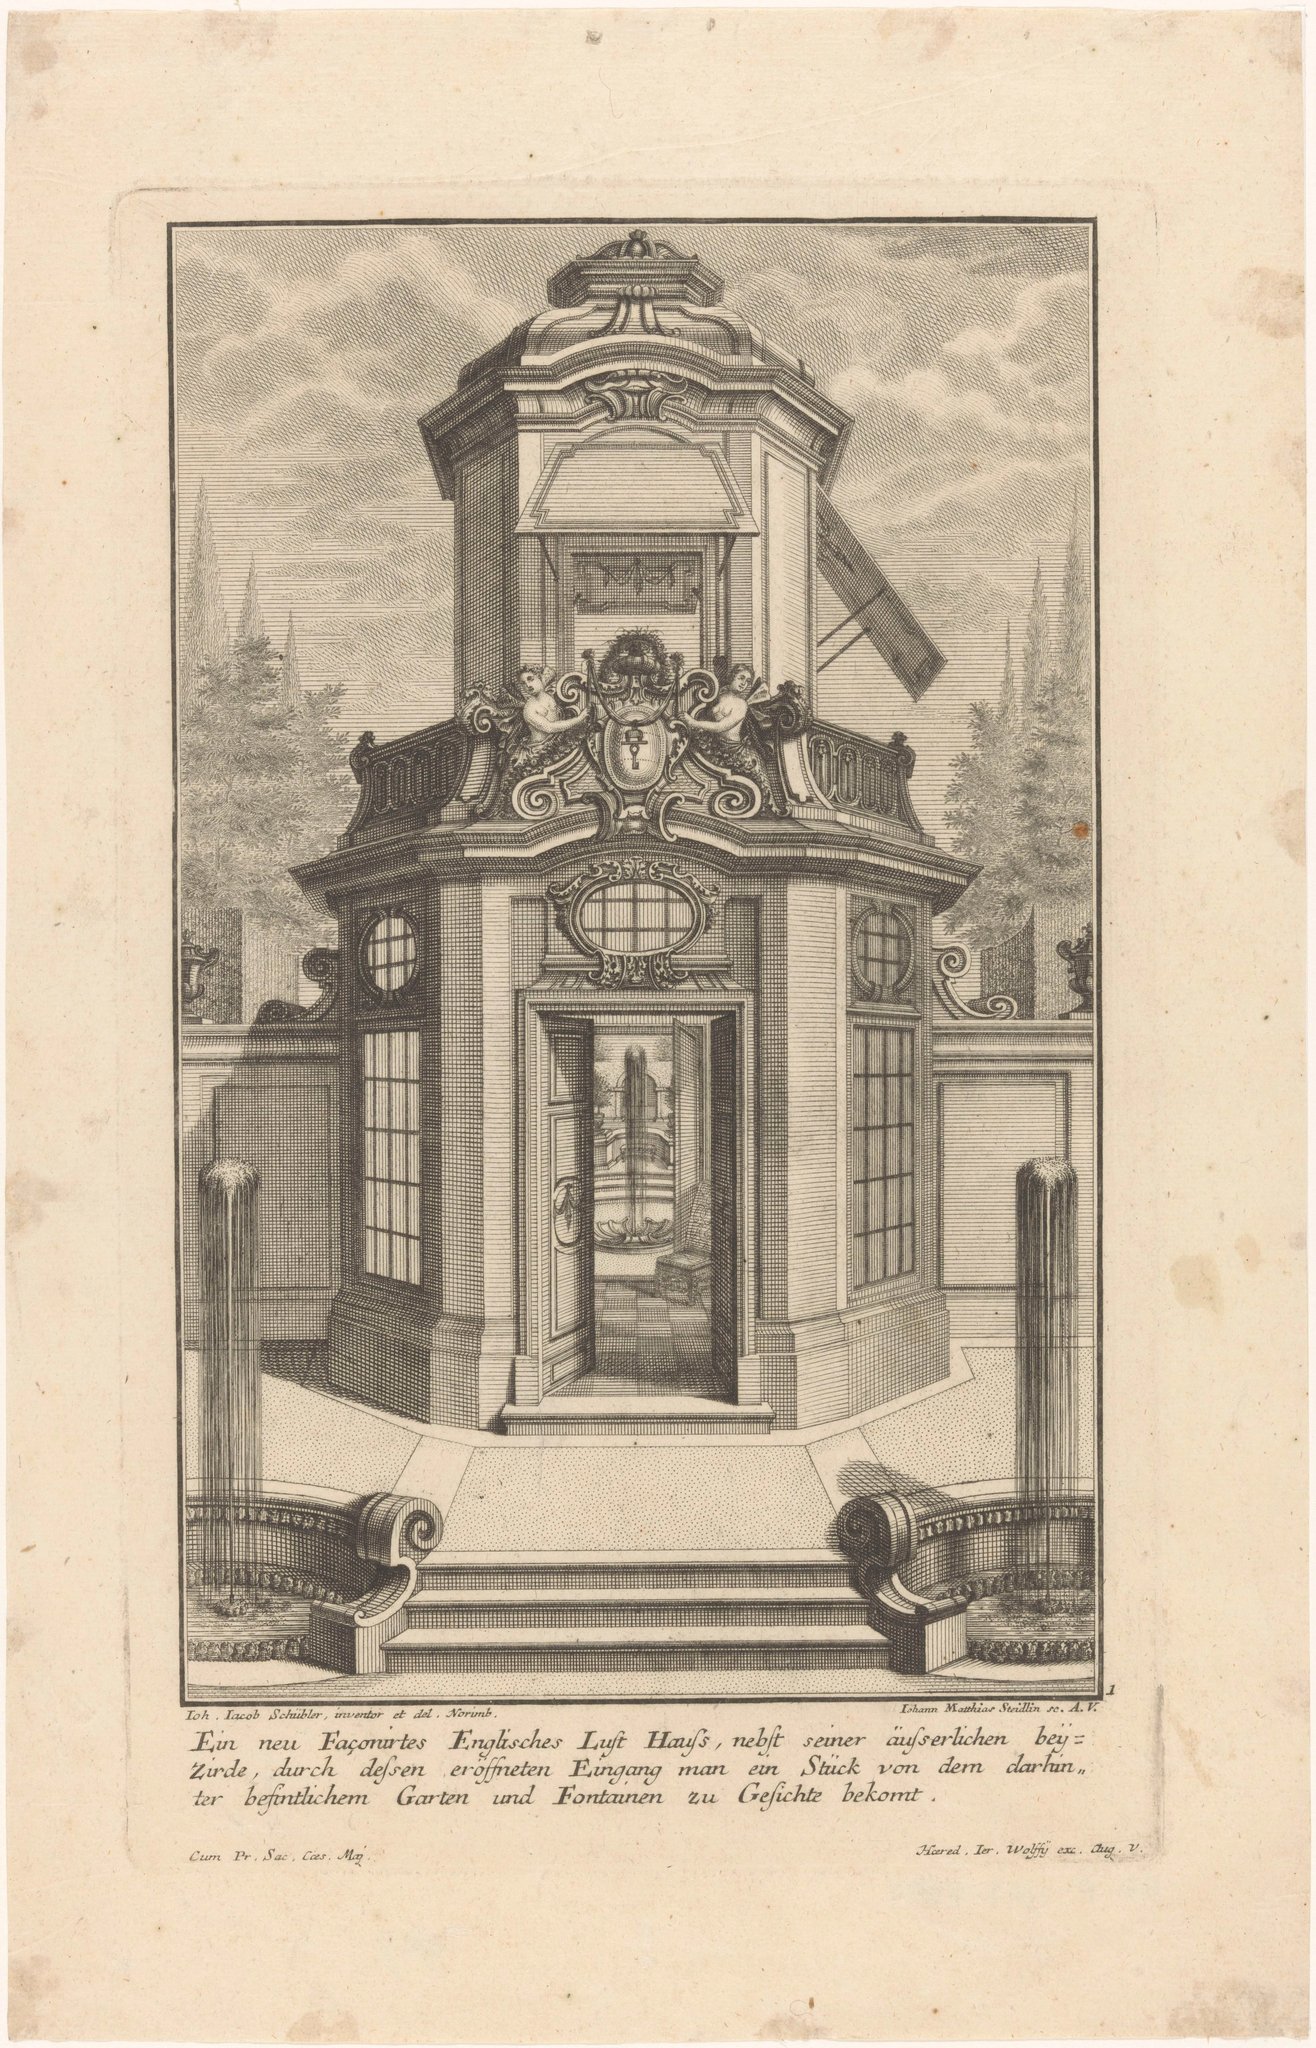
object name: ornament print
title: Johann Jacob Schüblers Siebende Ausgabe seines vorhabenden Wercks, Worinnen vorgestellet werden Neu-inventierte Sommer-Häuser, Garten-Cabinetten (...)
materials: paper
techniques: engraving, etching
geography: augsburg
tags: garden fountain, summer-house, arbour, garden-house (dutch: 'theekoepel'), cupids: 'amores', 'amoretti', 'putti'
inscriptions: collector's mark: Lugt 2228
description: Een geornamenteerd tuinhuis met putti en wapenschild. De deur van het tuinhuis is geopend en biedt een doorkijk naar een tuin met fontein in de achtergrond. Op de voorgrond twee fonteinen. In de ondermarge een drieregelige Duitse tekst.